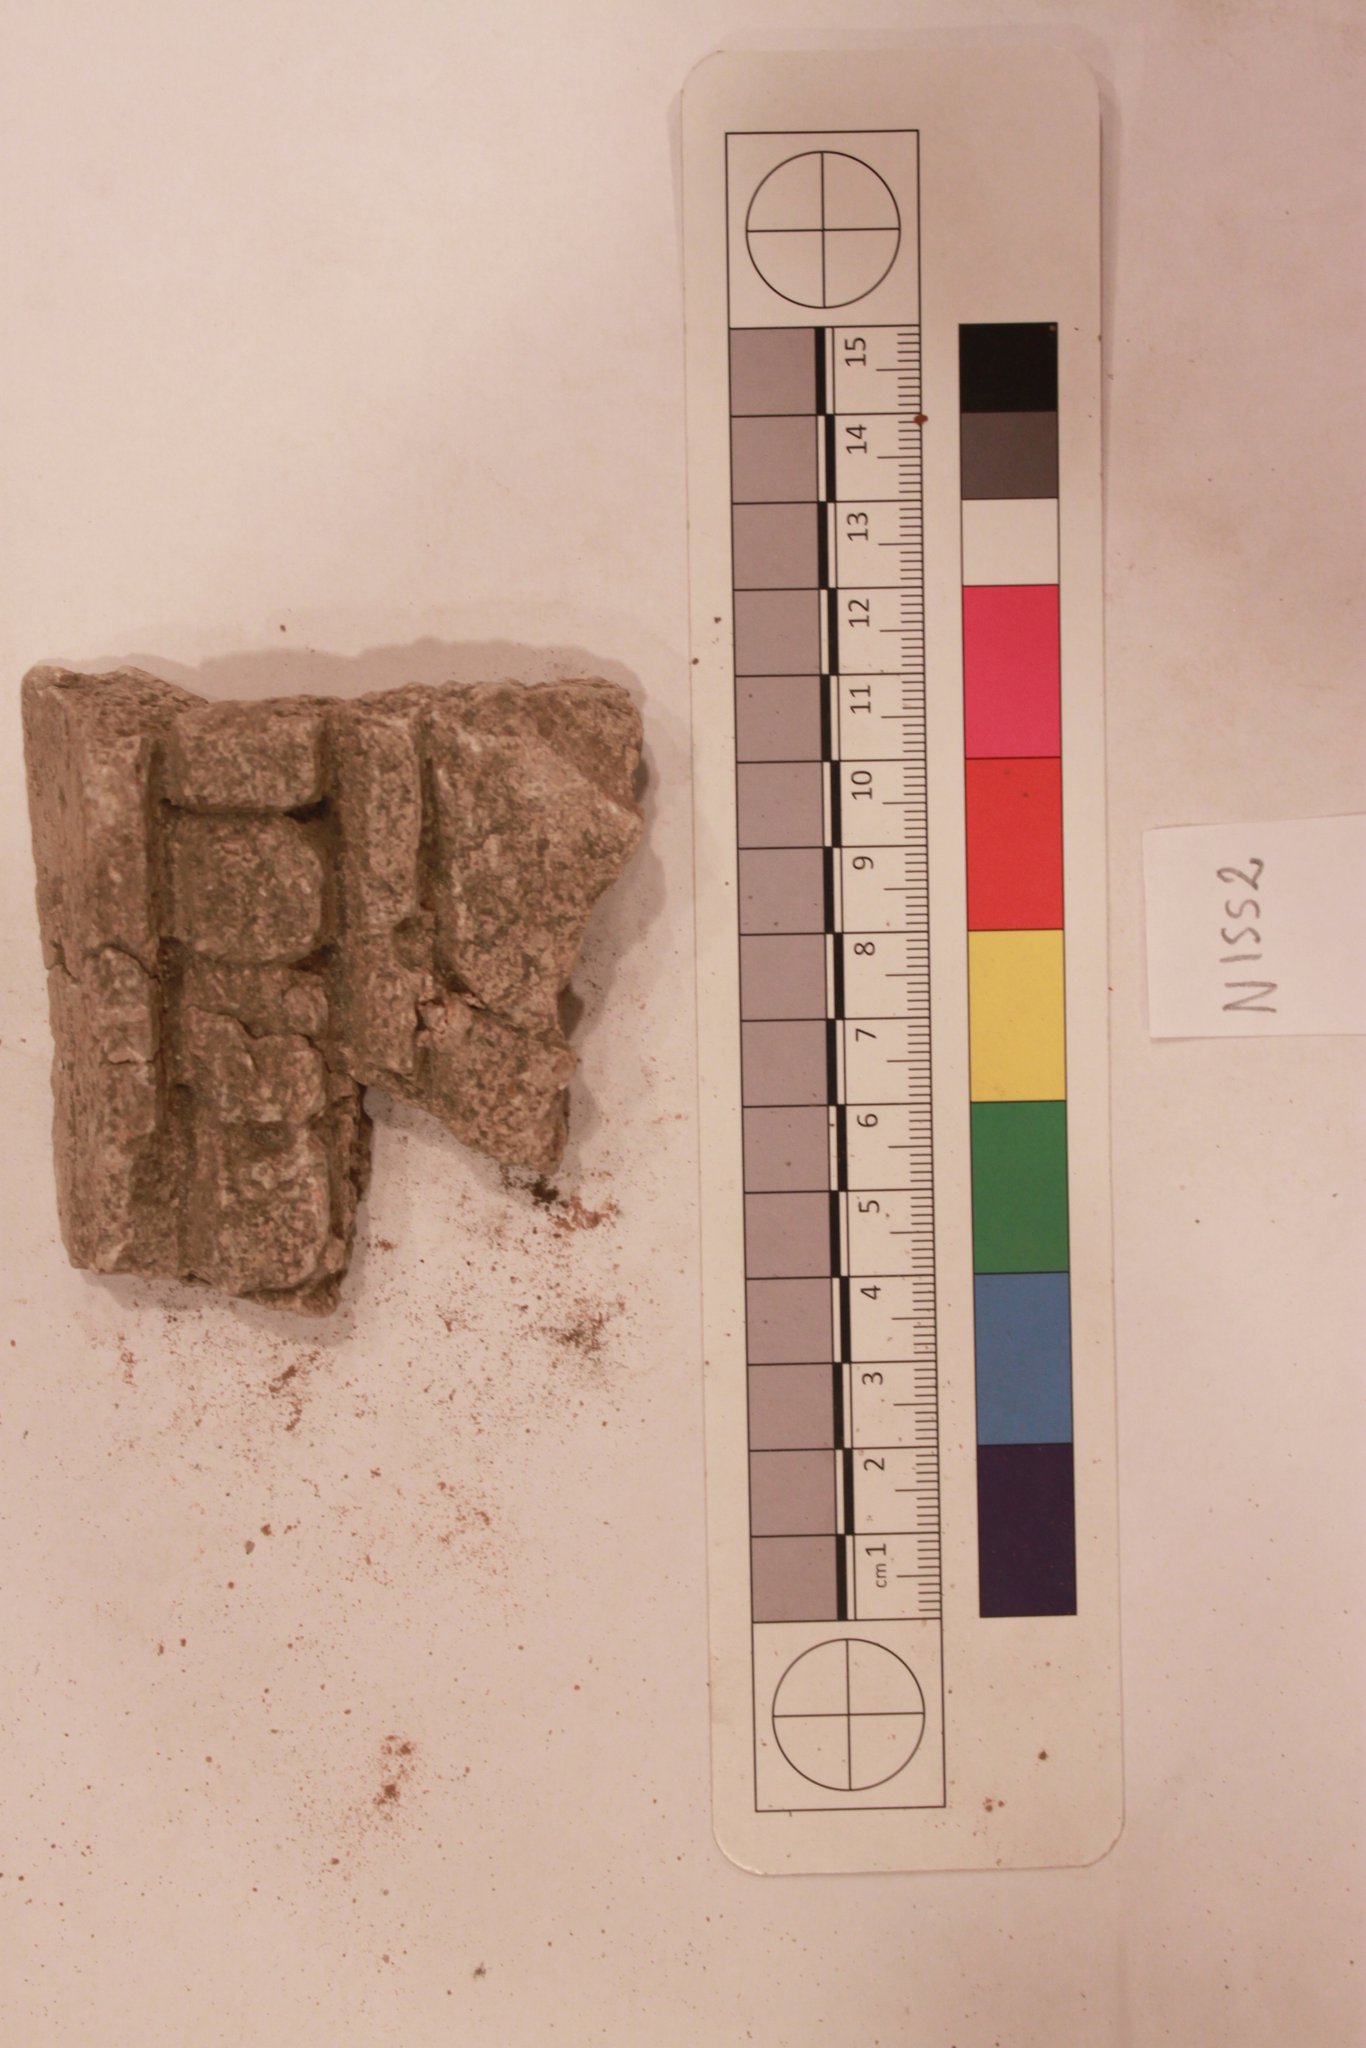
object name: fragment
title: Stucco Fragment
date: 701-1200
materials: plaster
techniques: carving, painting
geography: iran